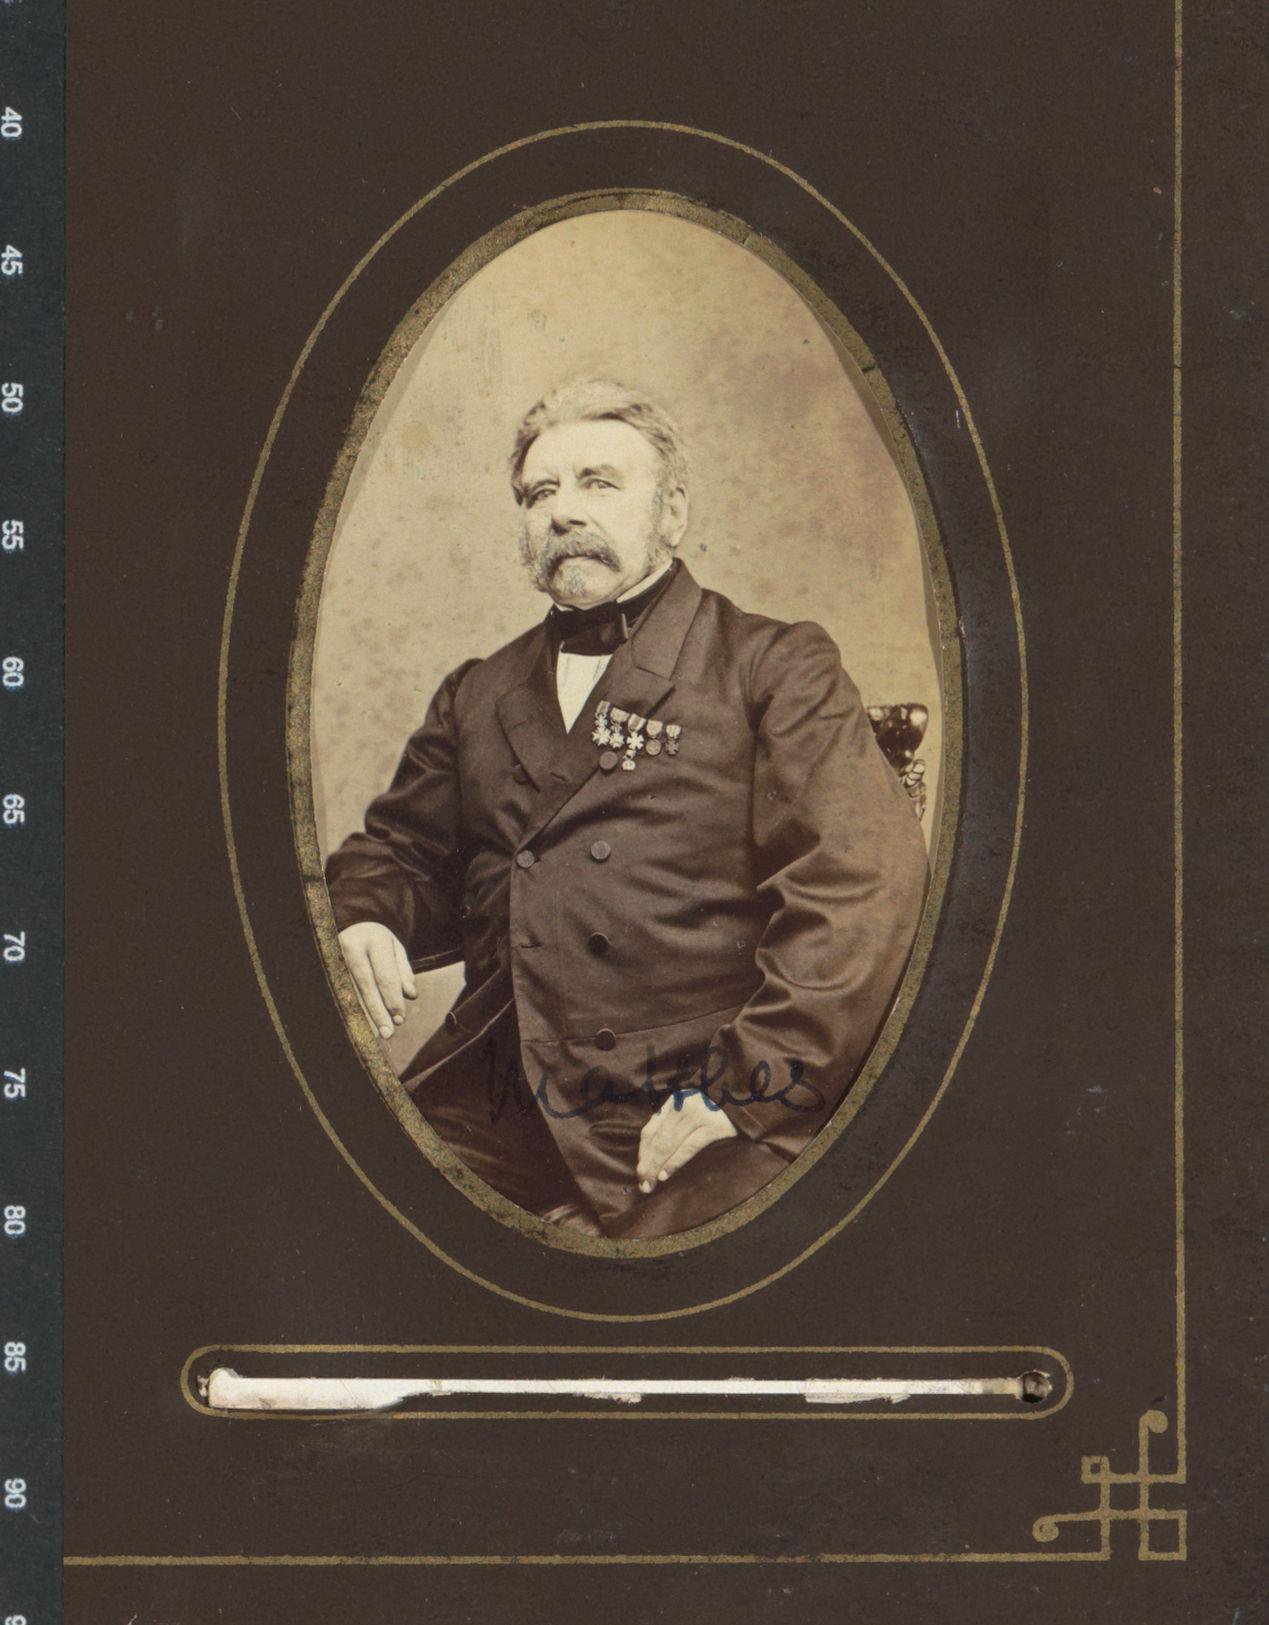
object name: carte de visite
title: Portret van de heer Matthes met medailles op de borst, zittend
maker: Anonymous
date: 1900-1930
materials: cardboard, paper, photographic support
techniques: albumen print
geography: netherlands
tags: adult man, historical persons, decorations, honours (as symbols of the state, etc.), netherlands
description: Onderdeel van Fotoalbum van de families Matthes, Doorman en Van Thiel.